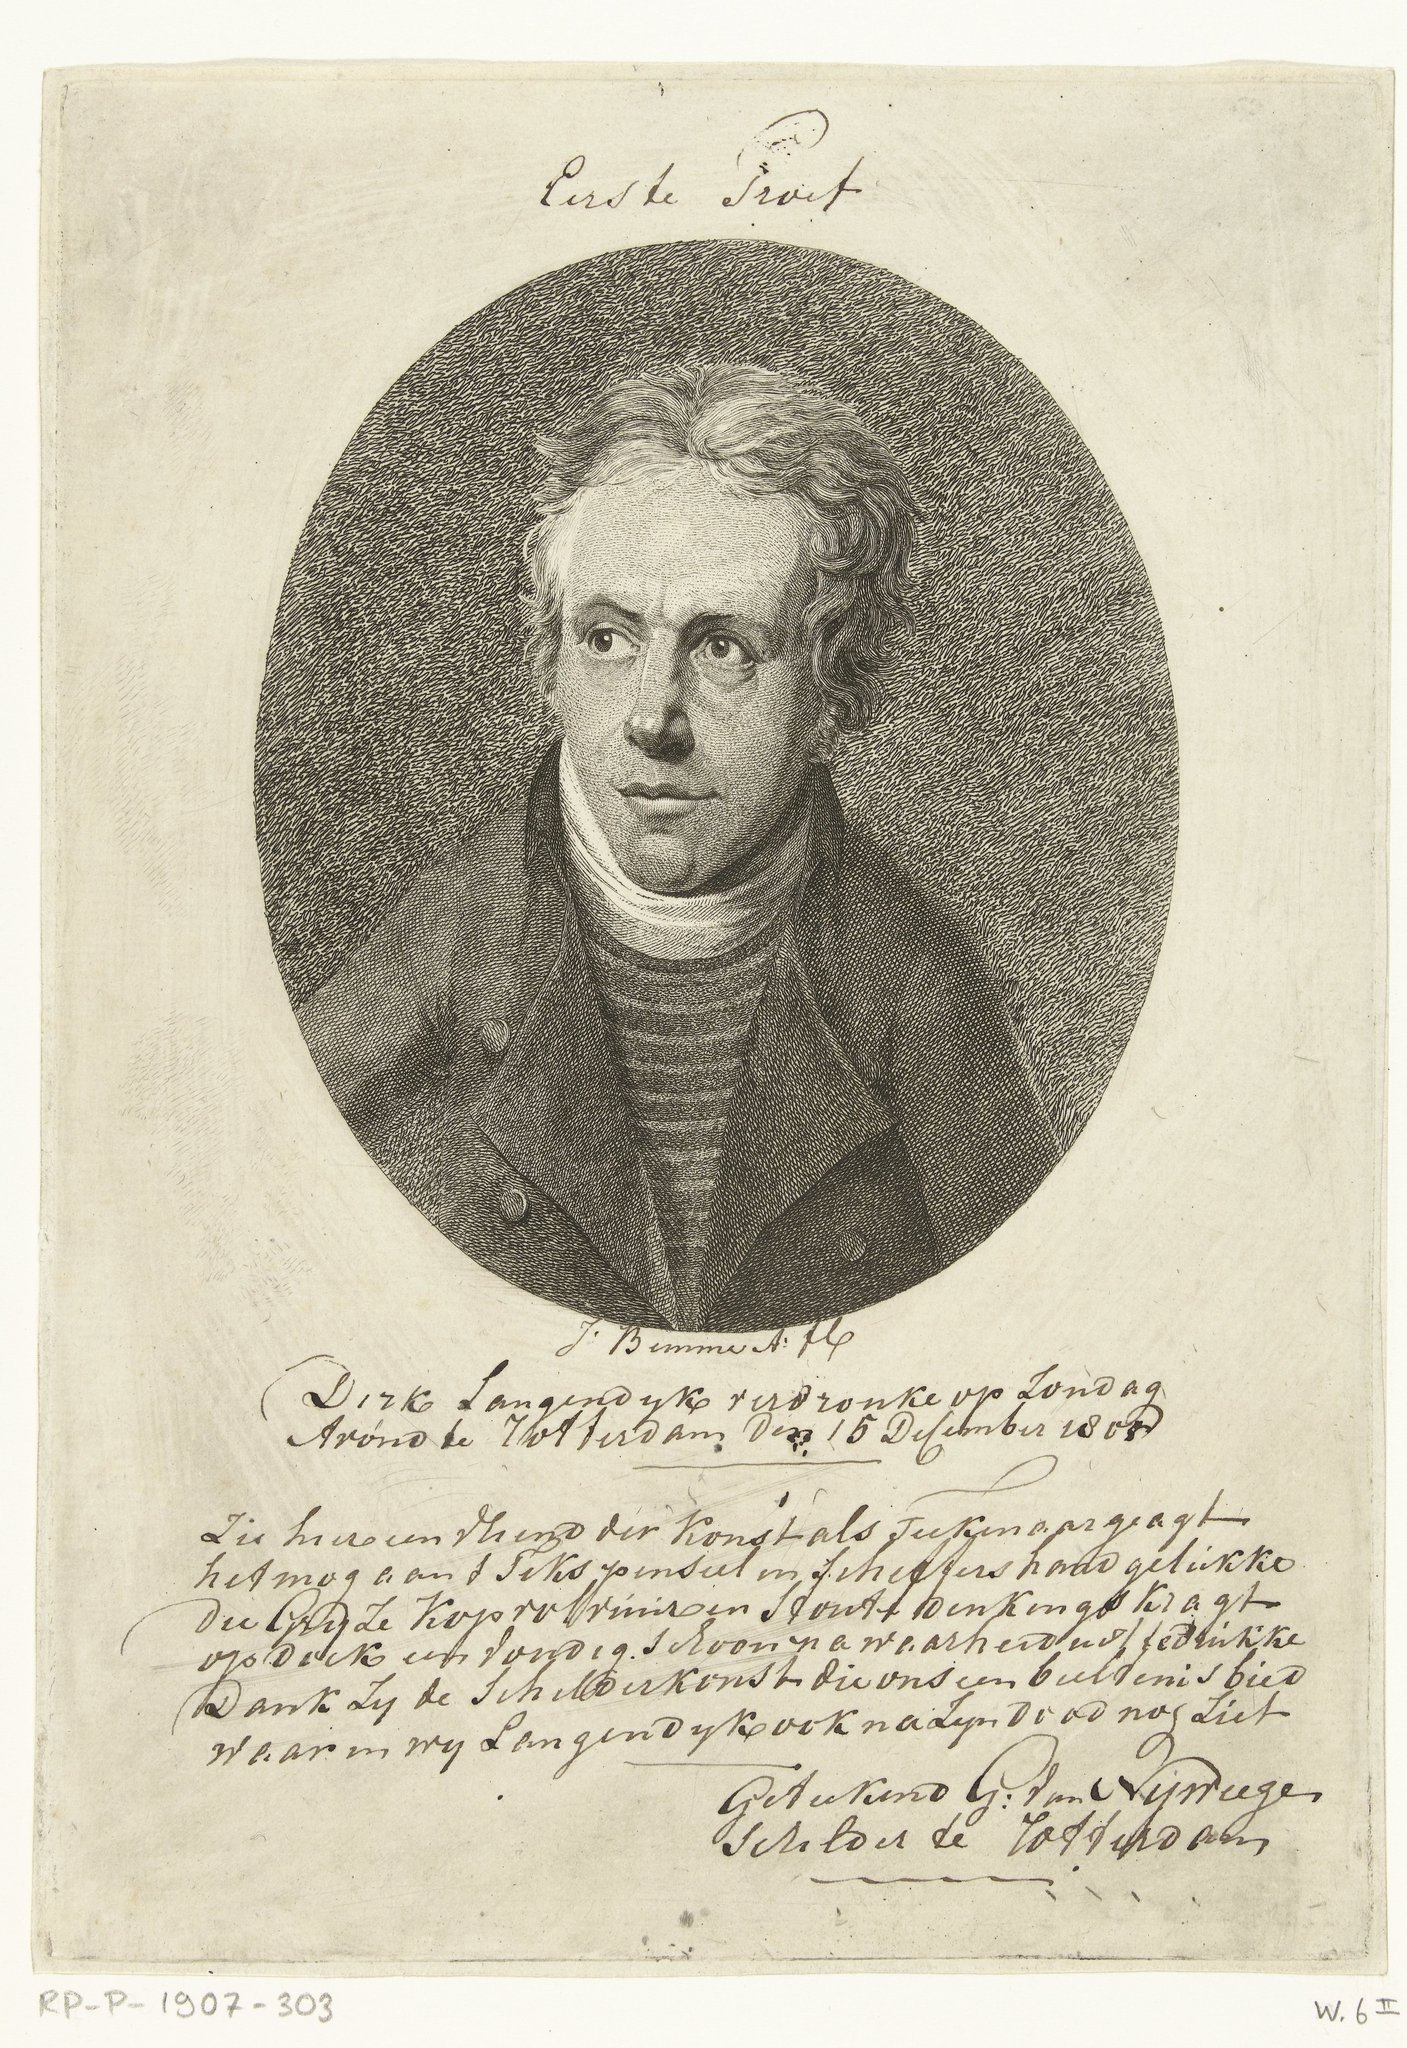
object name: print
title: Portret van Dirk Langendijk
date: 1805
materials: paper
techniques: etching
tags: rotterdam, painter, dirk langendijk, art (+ portrait, self-portrait of artist)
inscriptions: inscription: ‘Eerste Proef [...] Dirk Langendyk verdronke op zondag [...] Getekend G. van Nymegen Schilder te Rotterdam’, collector's mark: Lugt 2228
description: Portret van Dirk Langendijk. Onder het portret een elegie van Gerard van Nijmegen op de kunstenaar in handschrift.